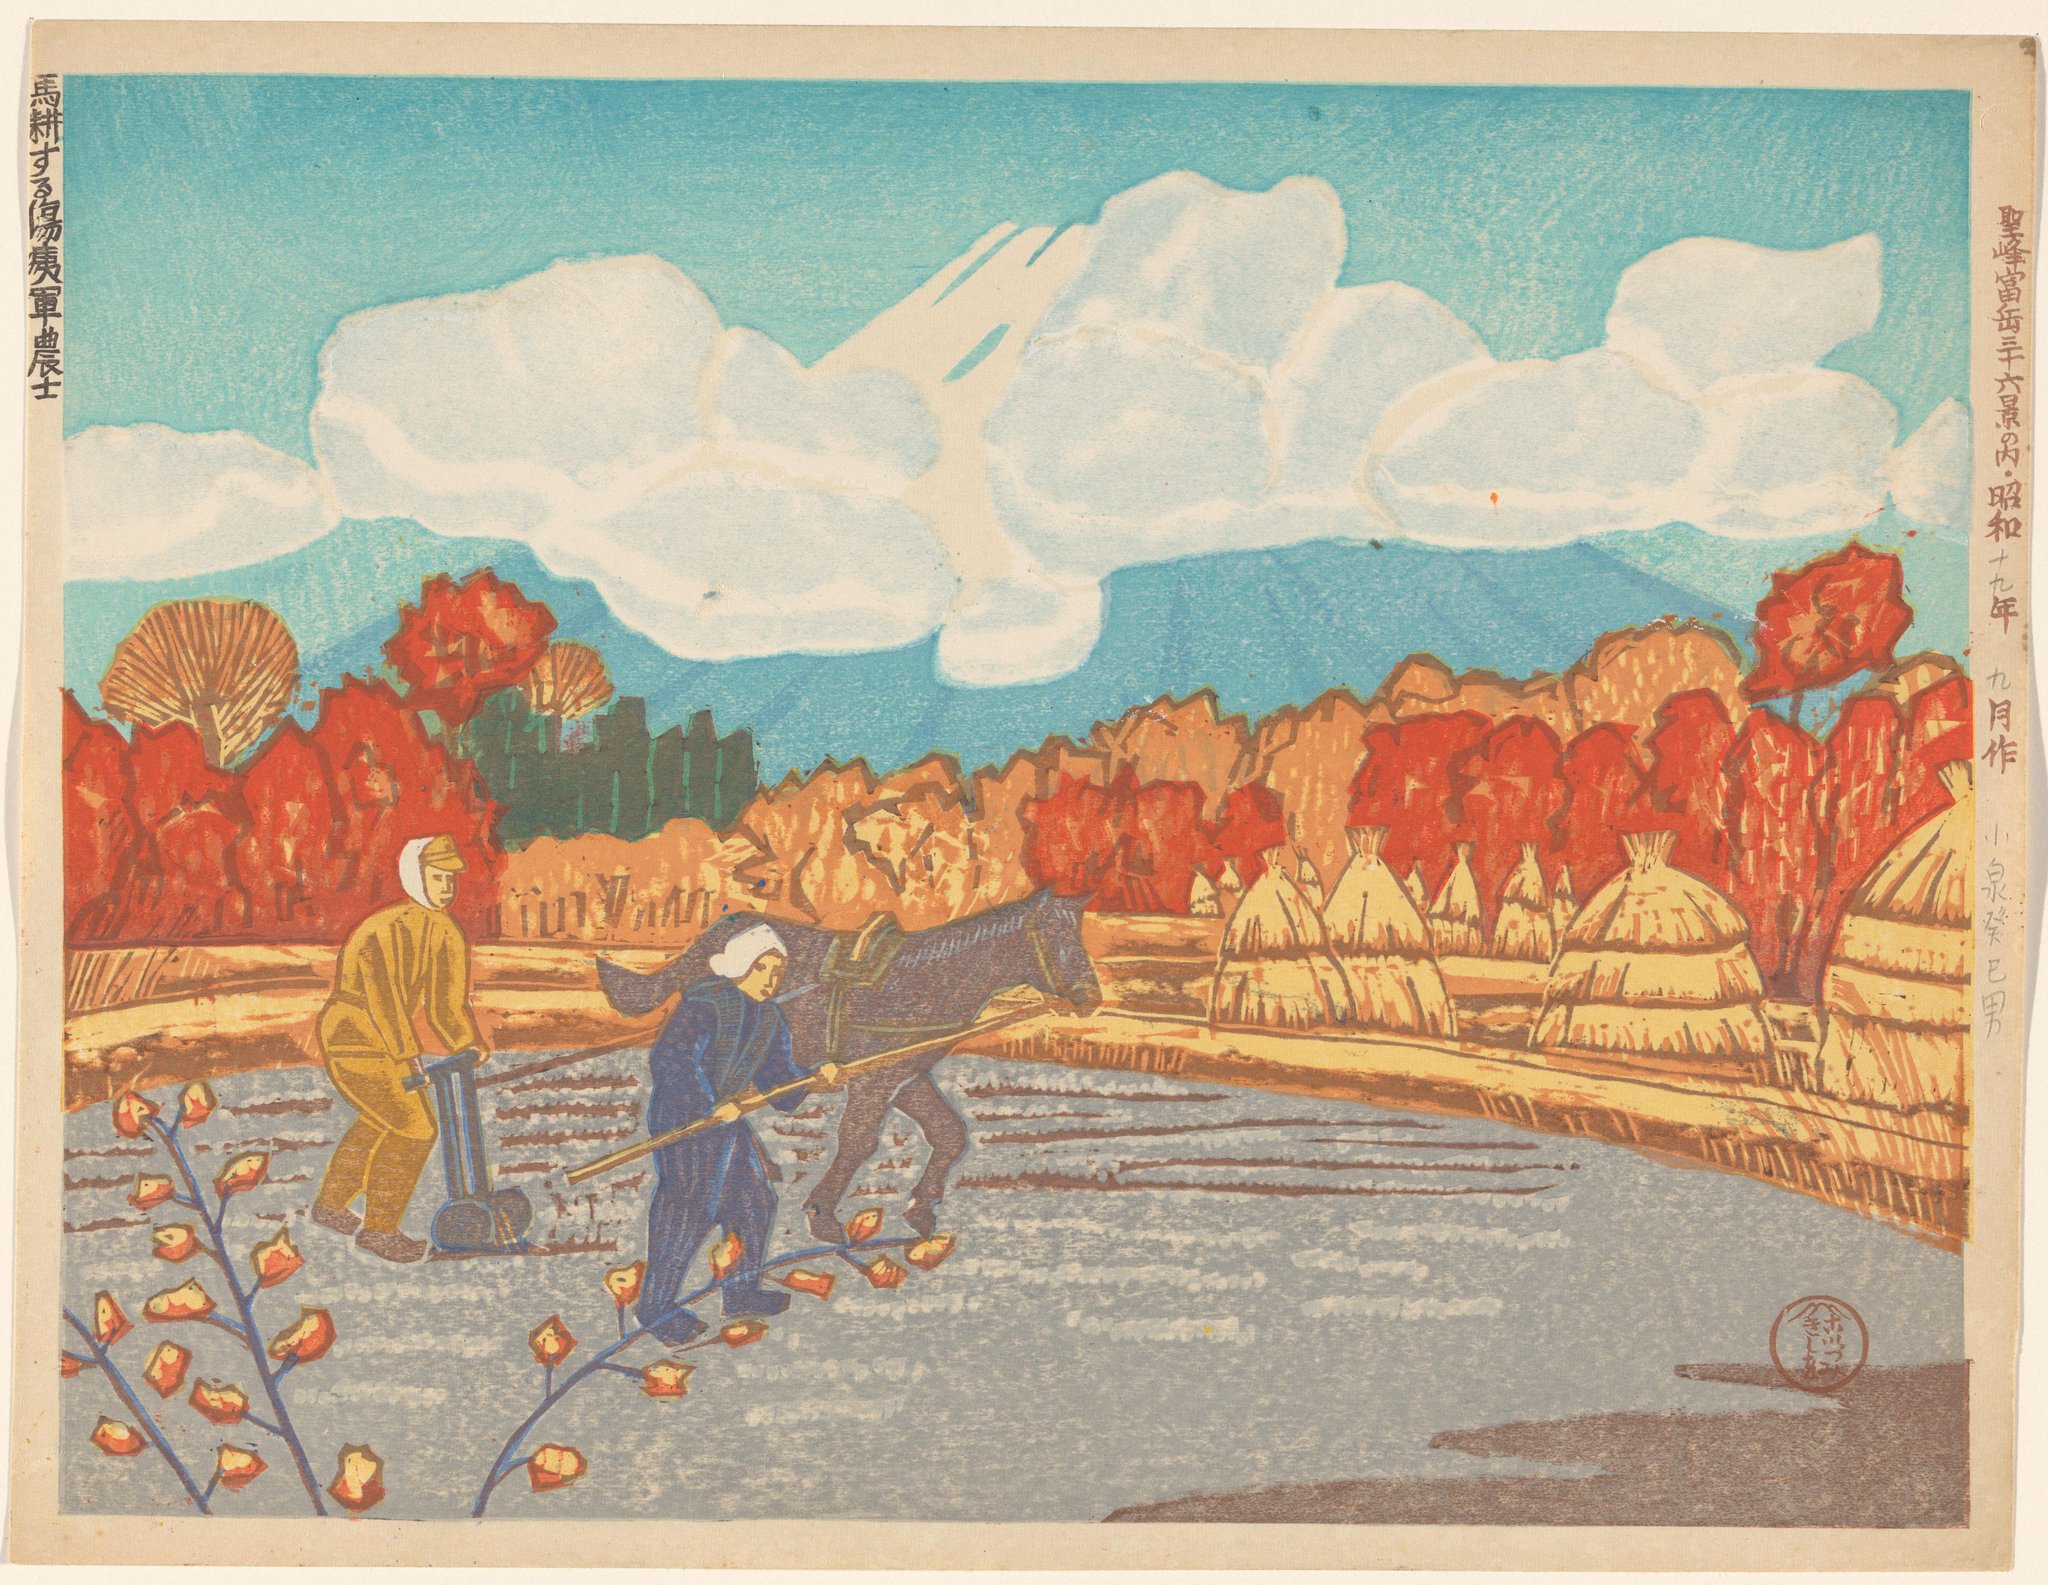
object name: print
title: Thirty-six views of the sacred peak of mount Fuji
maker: koizumi kishio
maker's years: 1893-1945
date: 1909-1944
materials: paper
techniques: woodcut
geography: japan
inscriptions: seal: ‘こいづみきしを’, signature: ‘小泉癸巳男’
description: Een gewonde soldaat en een boerin ploegen een veld met een paard in een kleurrijk herfstlandschap. De Fuji-berg is deels verscholen achter een groep wolken. oizumi Kishio begon in 1940 aan zijn project 'Zesendertig gezichten op de heilige berg Fuji', een knipoog naar de welbekende prenten uit de jaren 1830 van Katsushika Hokusai (1760–1849). Vanwege de geallieerde bombardementen vluchtte hij naar zijn schoonouders in Saitama, ten noorden van Tokyo. Hij voltooide 23 ontwerpen voor hij bezweek aan ziekte in 1945.